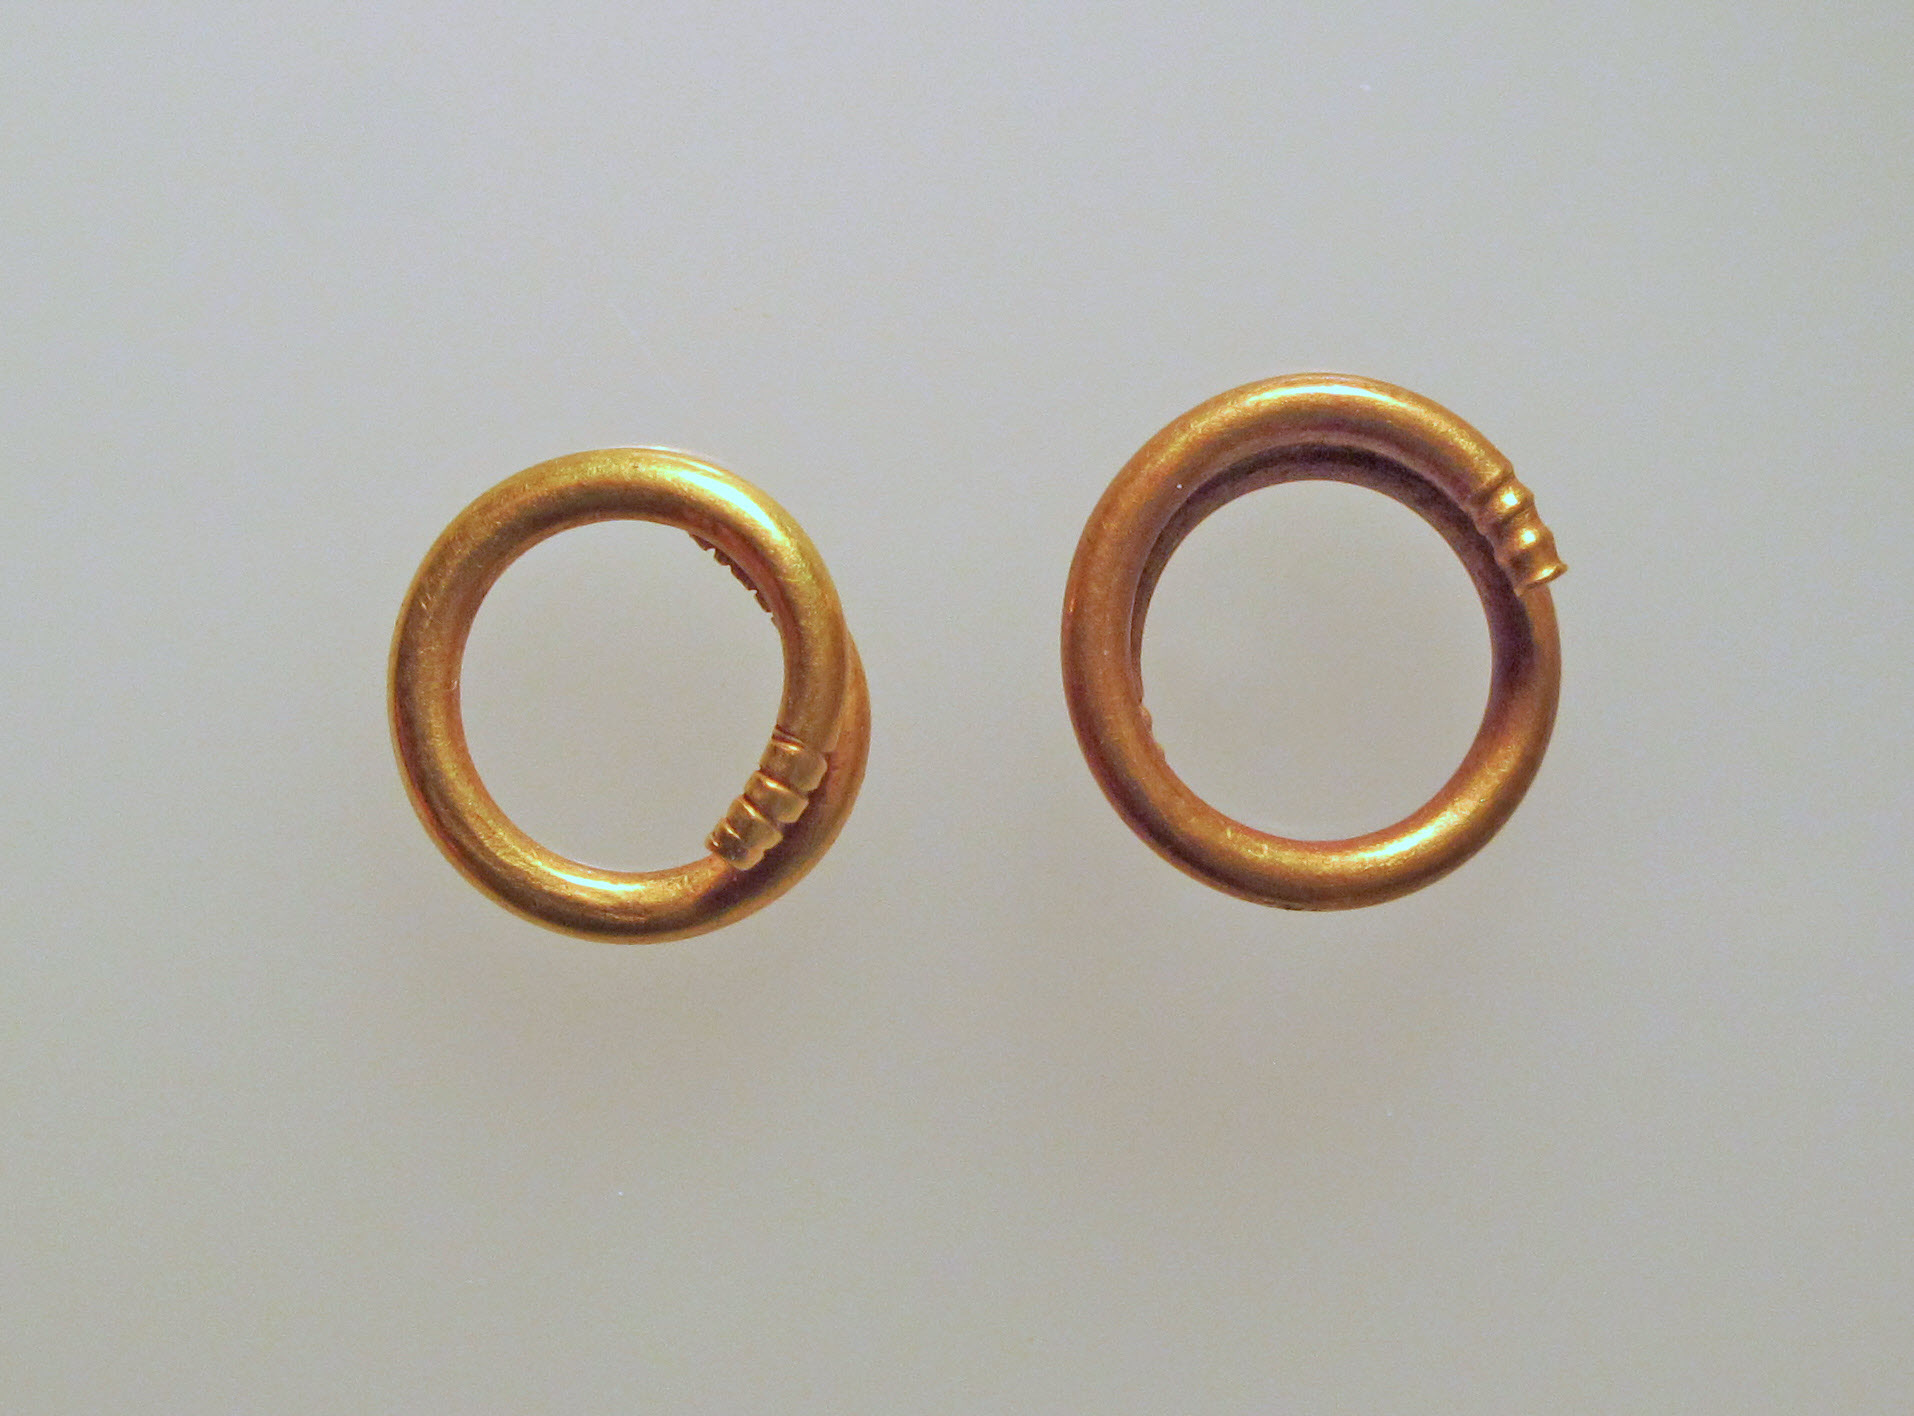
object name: spiral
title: Spirals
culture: cypriot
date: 3900 BCE-100 CE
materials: gold